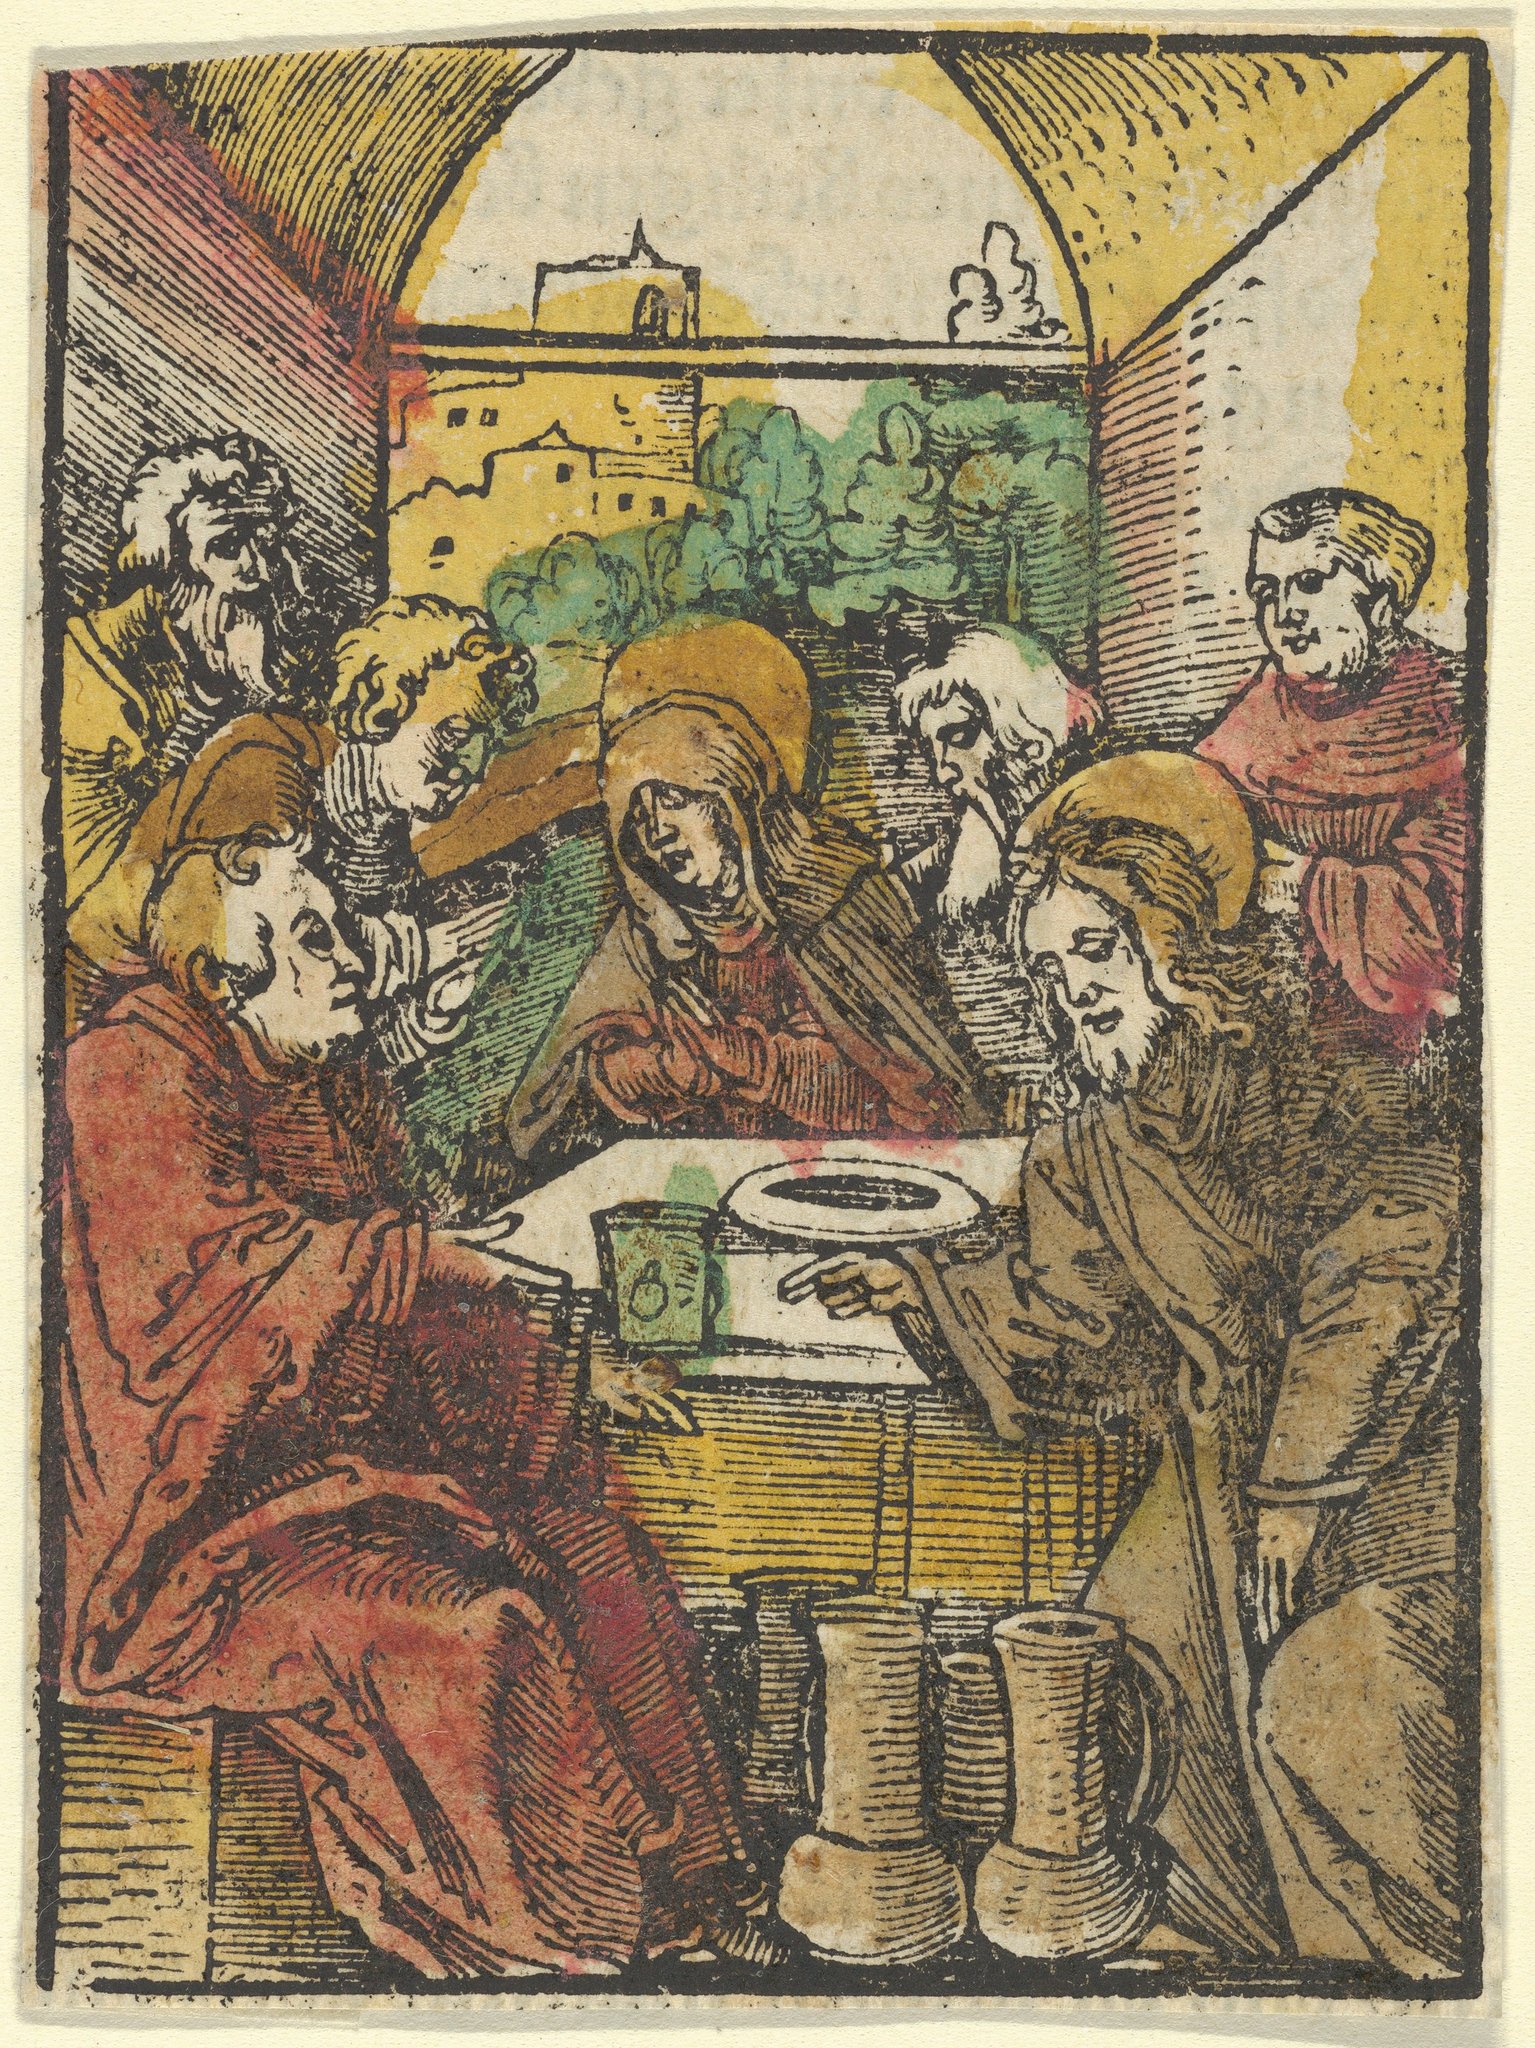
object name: print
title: The Wedding at Cana, from Das Plenarium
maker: hans schäufelein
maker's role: artist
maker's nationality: german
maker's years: 1480-1540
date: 1517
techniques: hand coloring, woodcut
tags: christ,virgin mary,saints,ceremony